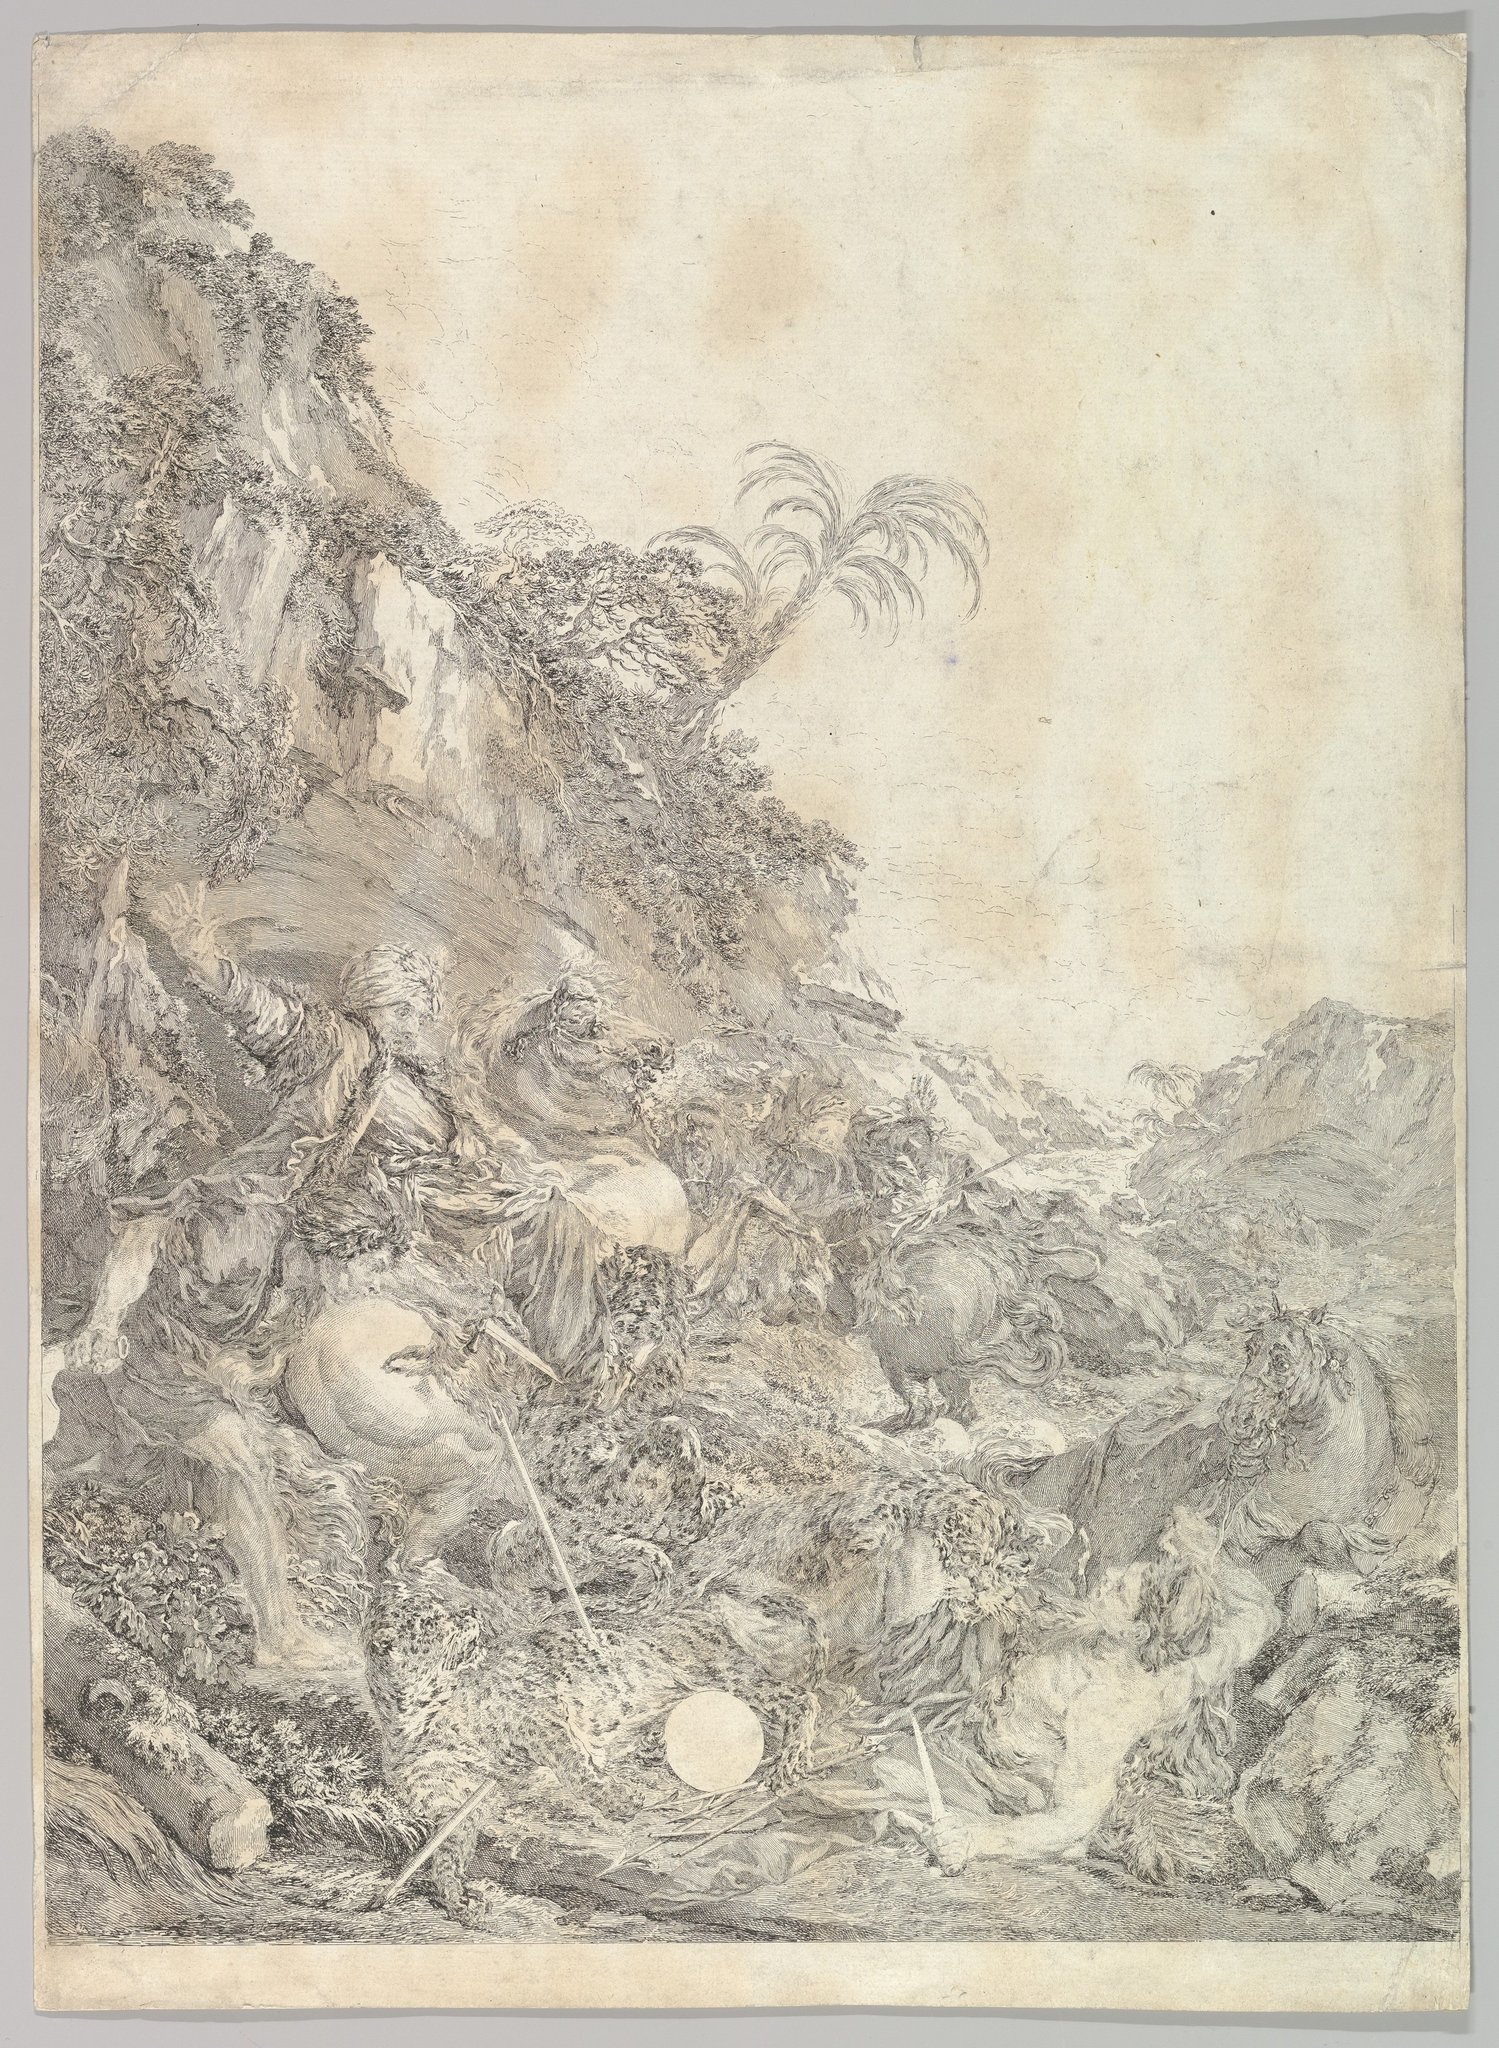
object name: print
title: La Chasse au Tigre (The Tiger Chase)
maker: jean jacques flipart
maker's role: artist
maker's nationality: french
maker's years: 1719-1782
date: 1701-1800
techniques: etching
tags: men,hunting,horses,tigers